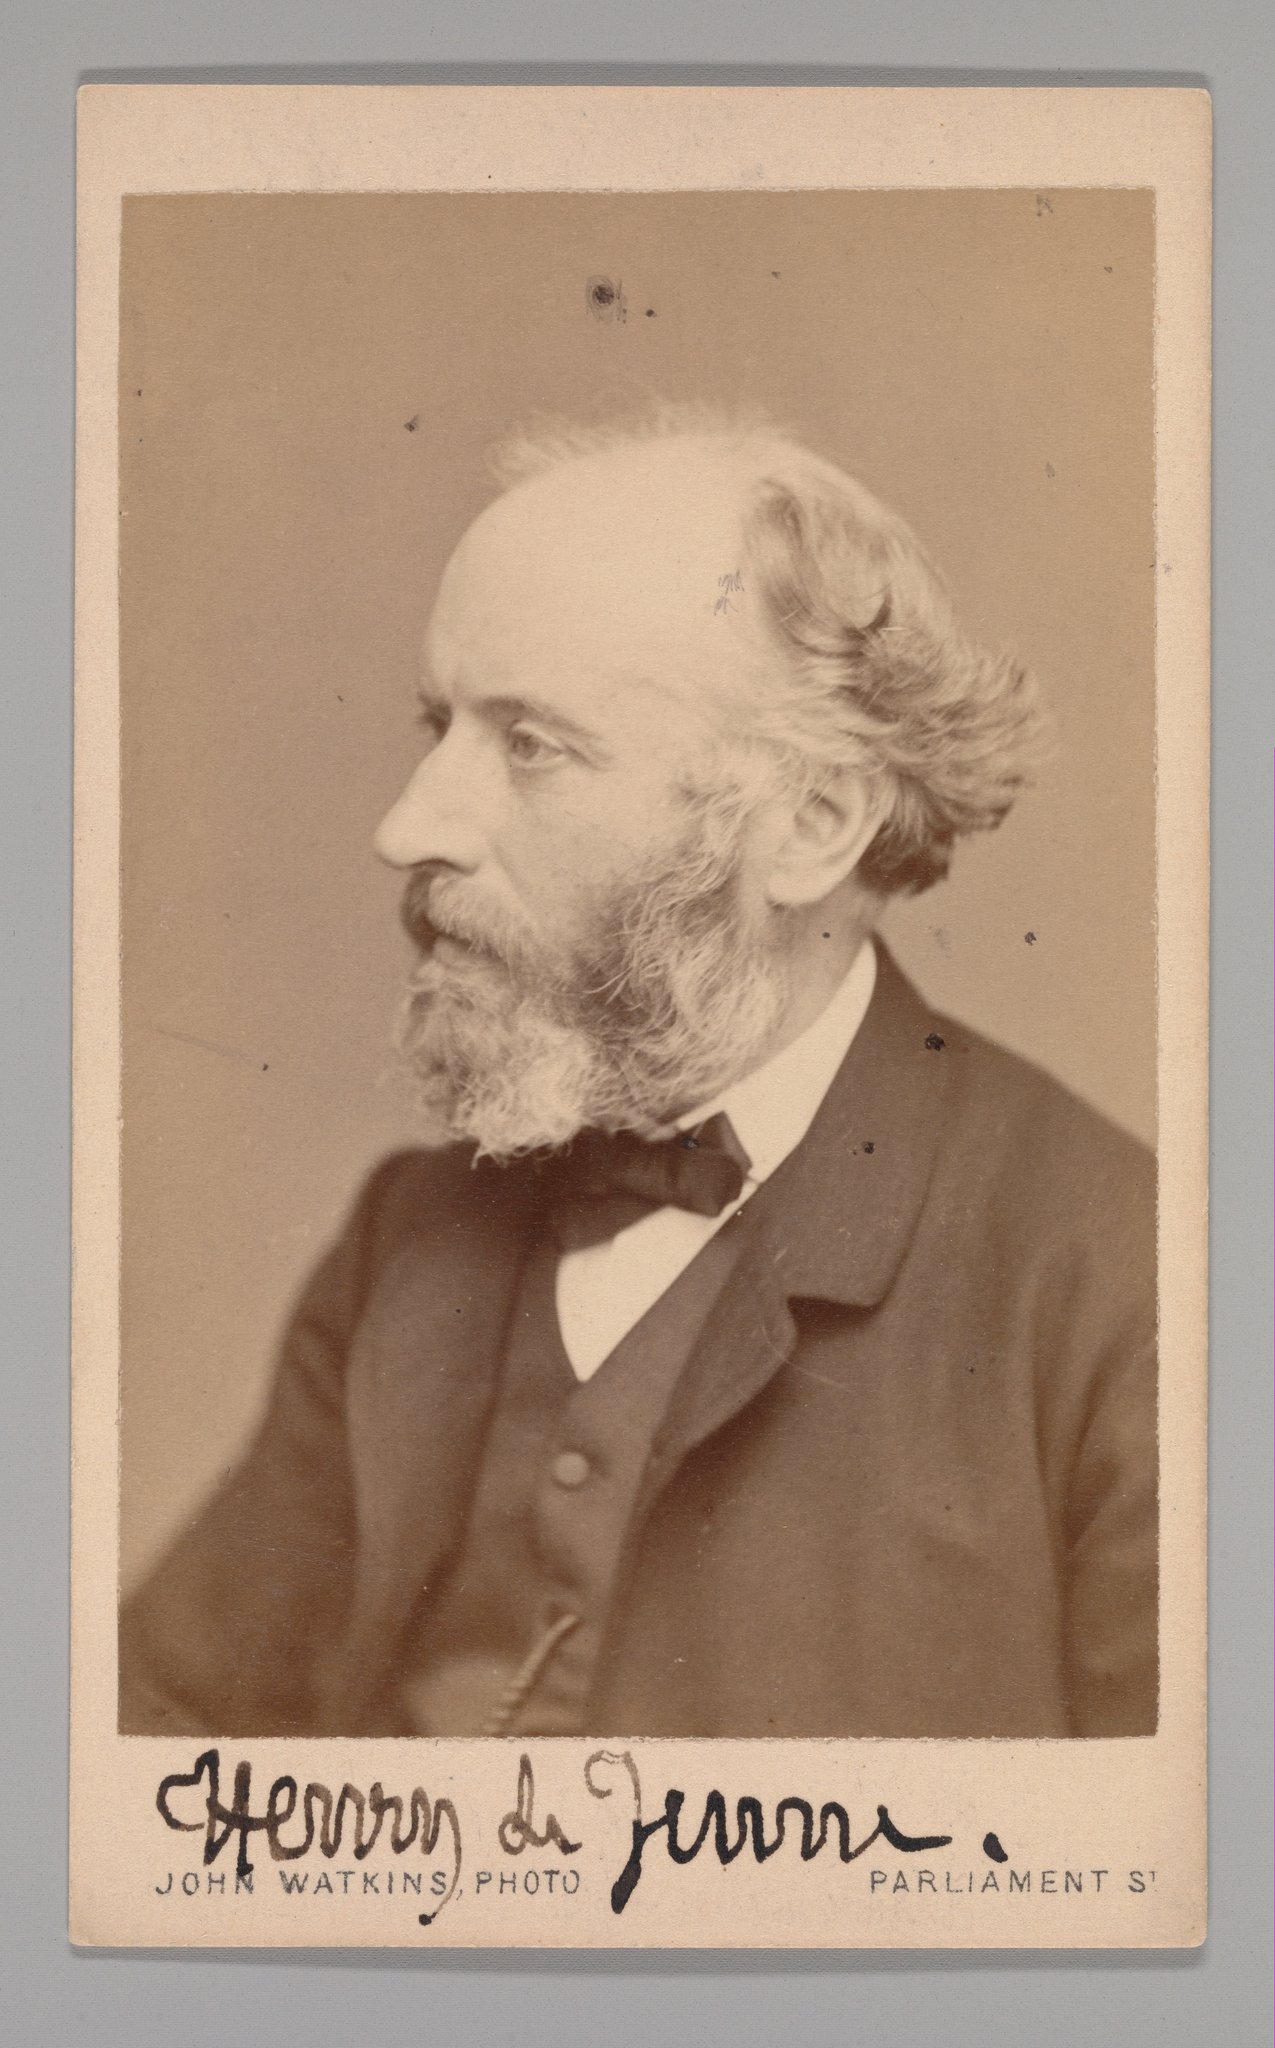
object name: carte de visite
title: [Henry LeJeune]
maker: john and charles watkins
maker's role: photography studio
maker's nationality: british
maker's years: 1840-1875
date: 1860-1869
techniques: albumen silver print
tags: men,portraits,profiles